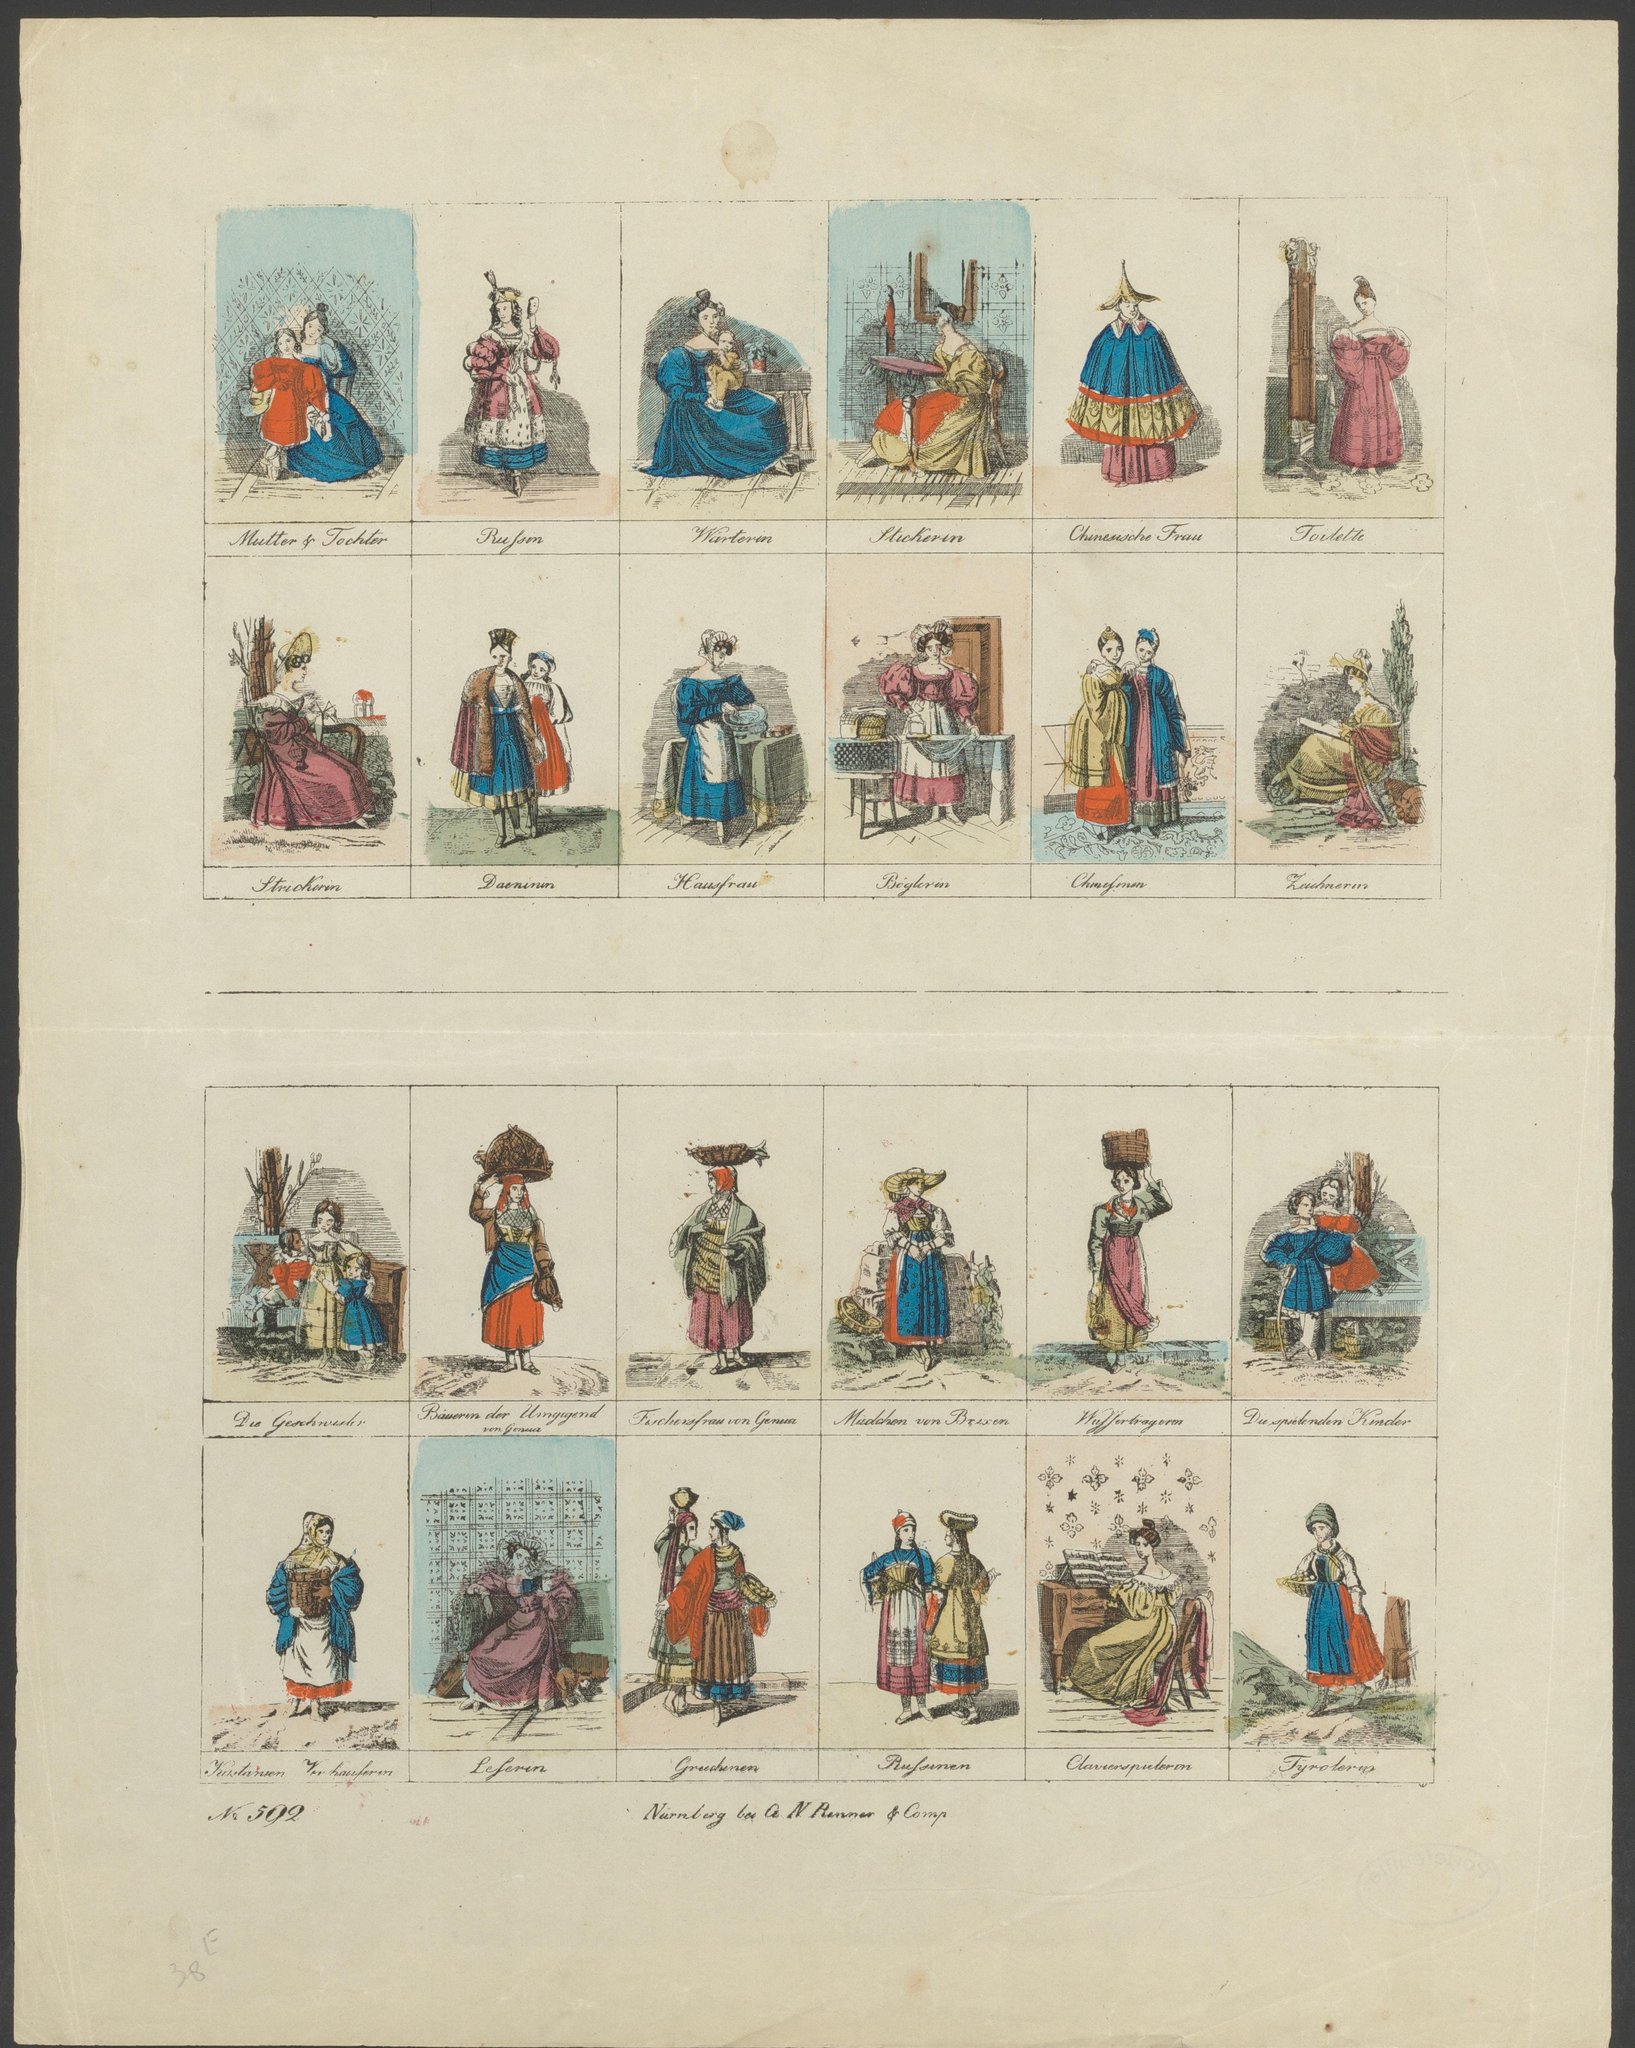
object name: print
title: Verschillende personen uit diverse landen en tijdens diverse activiteiten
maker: Anonymous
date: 1837-1868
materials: paper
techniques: hand coloring, lithograph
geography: nuremberg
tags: human types; peoples and nationalities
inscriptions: stamp, collector's mark: Lugt 1641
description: Vierentwintig voorstellingen van personen uit diverse landen en tijdens diverse activiteiten. Linksonder genummerd: No. 592. Onderwerpsrubrieken binnen de Atlas Zeden en Gewoonten: Zeden en Gewoonten in Engeren Zin, Des menschen beging, midden en einde, Kinderleven – Kinderspel en Kinderprenten.